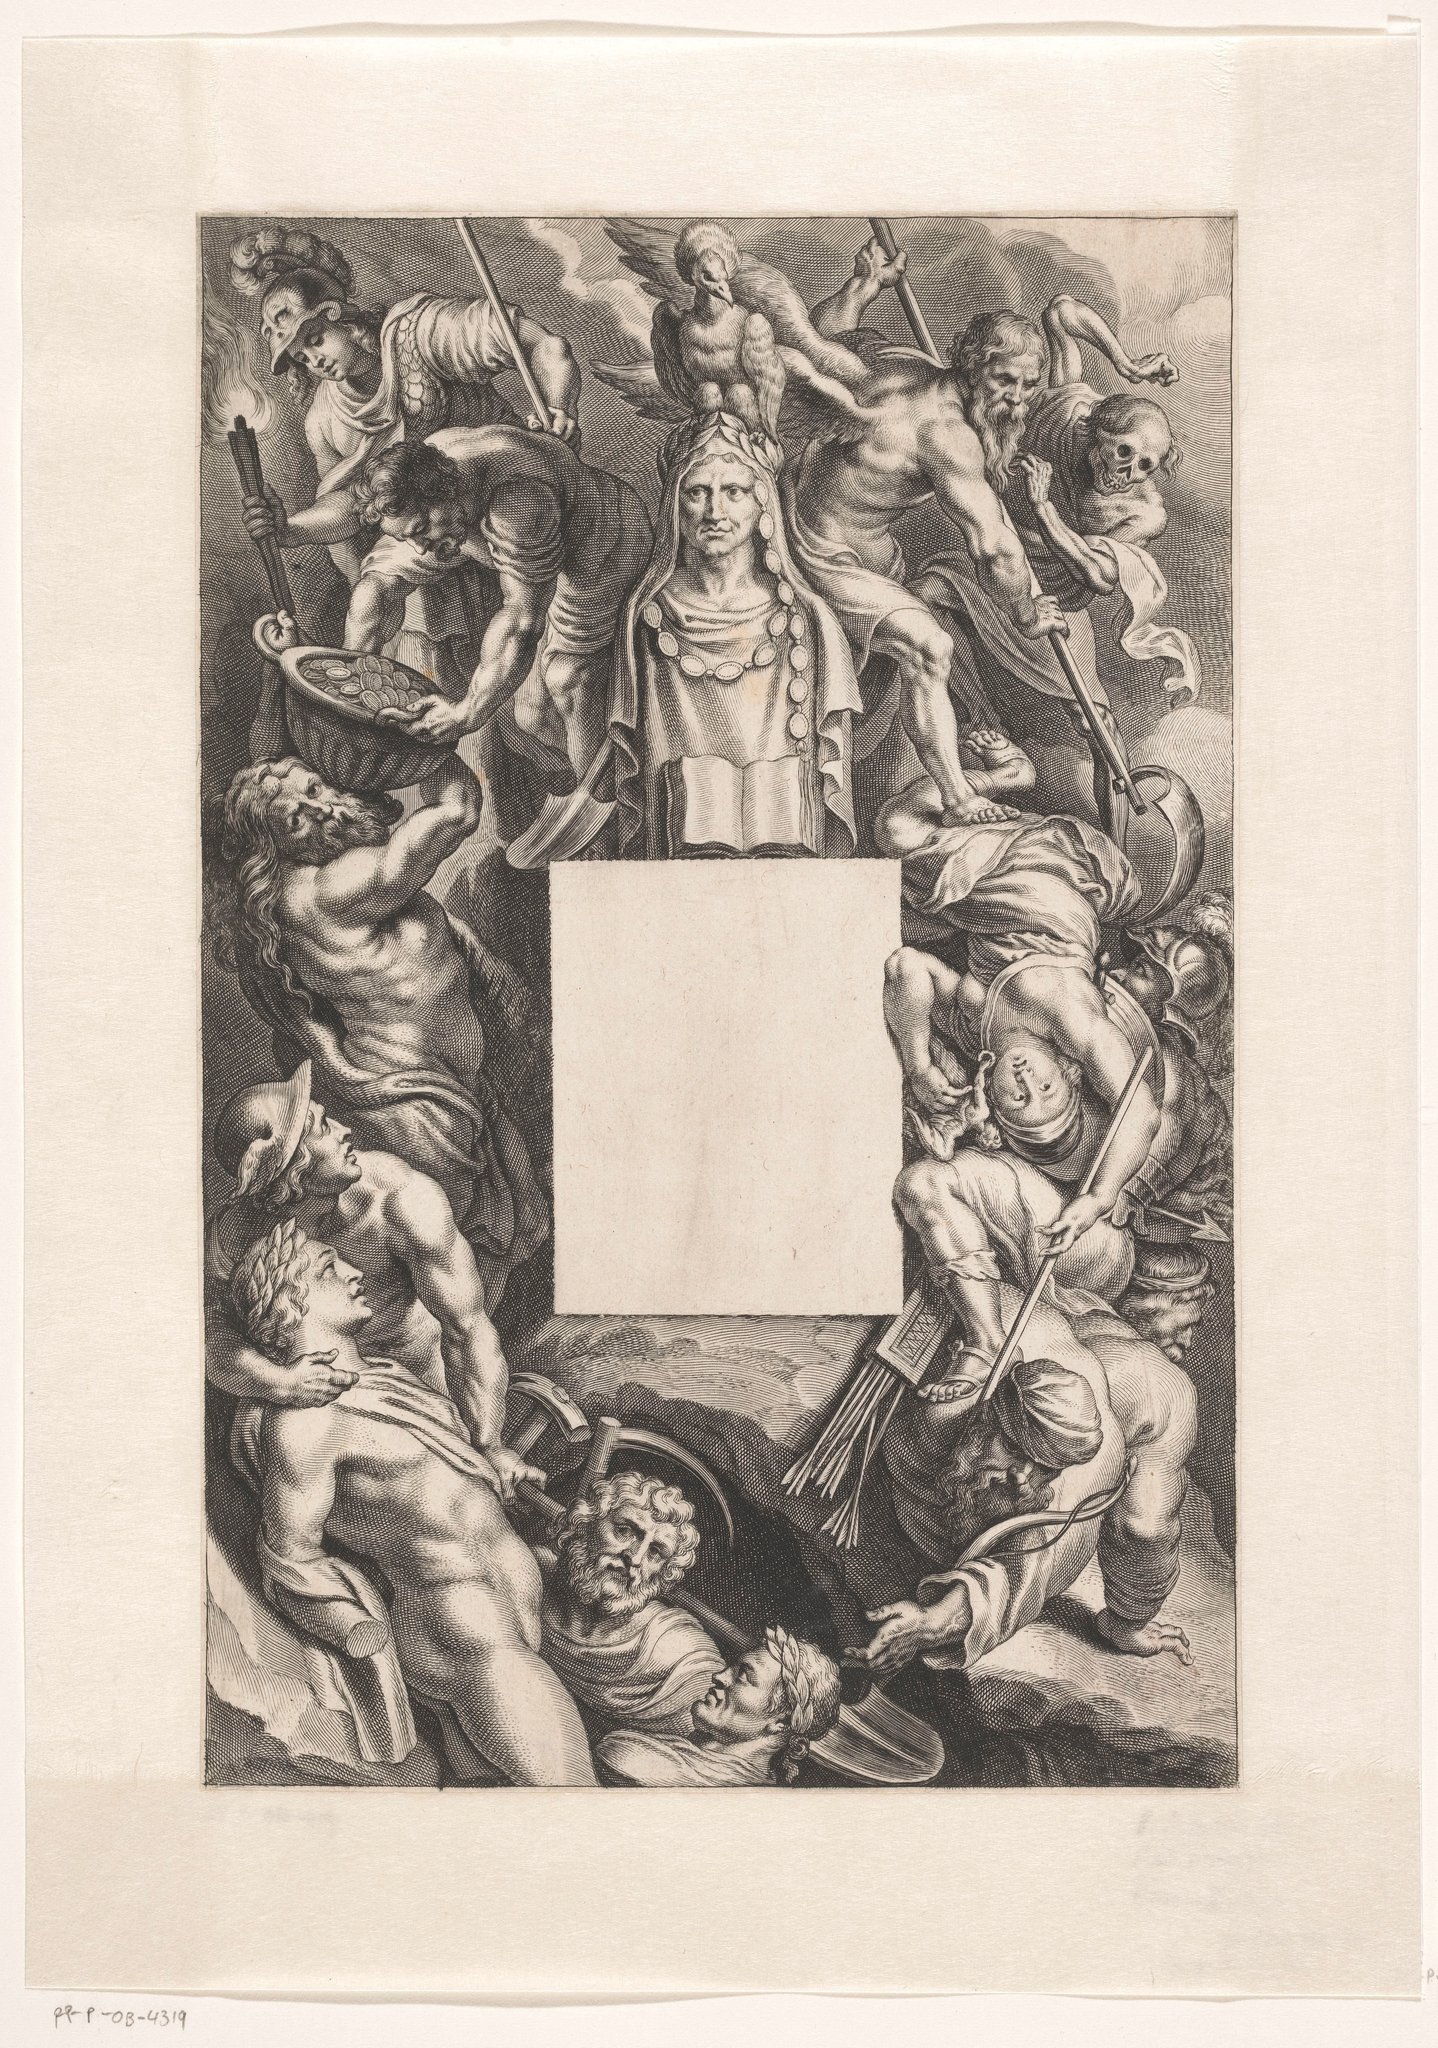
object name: titelblad, titelpagina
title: Redding van de antieke kunstschatten door de goden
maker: cornelis galle (i)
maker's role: print maker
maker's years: 1576-1650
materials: paper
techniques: engraving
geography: southern netherlands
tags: (story of) hercules (heracles), (story of) minerva (pallas, athena), (story of) mercury (hermes), death as man, classical antiquity (historical epoch), father time, man with wings and scythe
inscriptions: collector's mark: Lugt 240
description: Vader Tijd en de Dood stoten de vertegenwoordigers van de antieke culturen in een afgrond. De goden redden de antieke kunstschatten. Mercurius tilt een Romeins beeld uit een kuil, Hercules geeft een mand met oude munten door en Minerva helpt een man de mand in ontvangst te nemen. In het midden een buste van de personificatie van de Antieke, met lauwerkrans en boek. Proefdruk voor een titelpagina van een boek over de antieke kunstschatten.